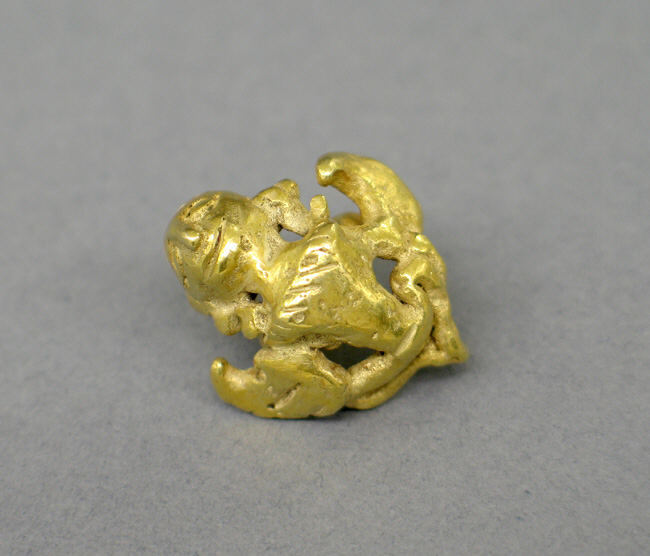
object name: ornament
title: Ear Ornament in the Shape of a Kinnara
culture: indonesian, javanese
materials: gold